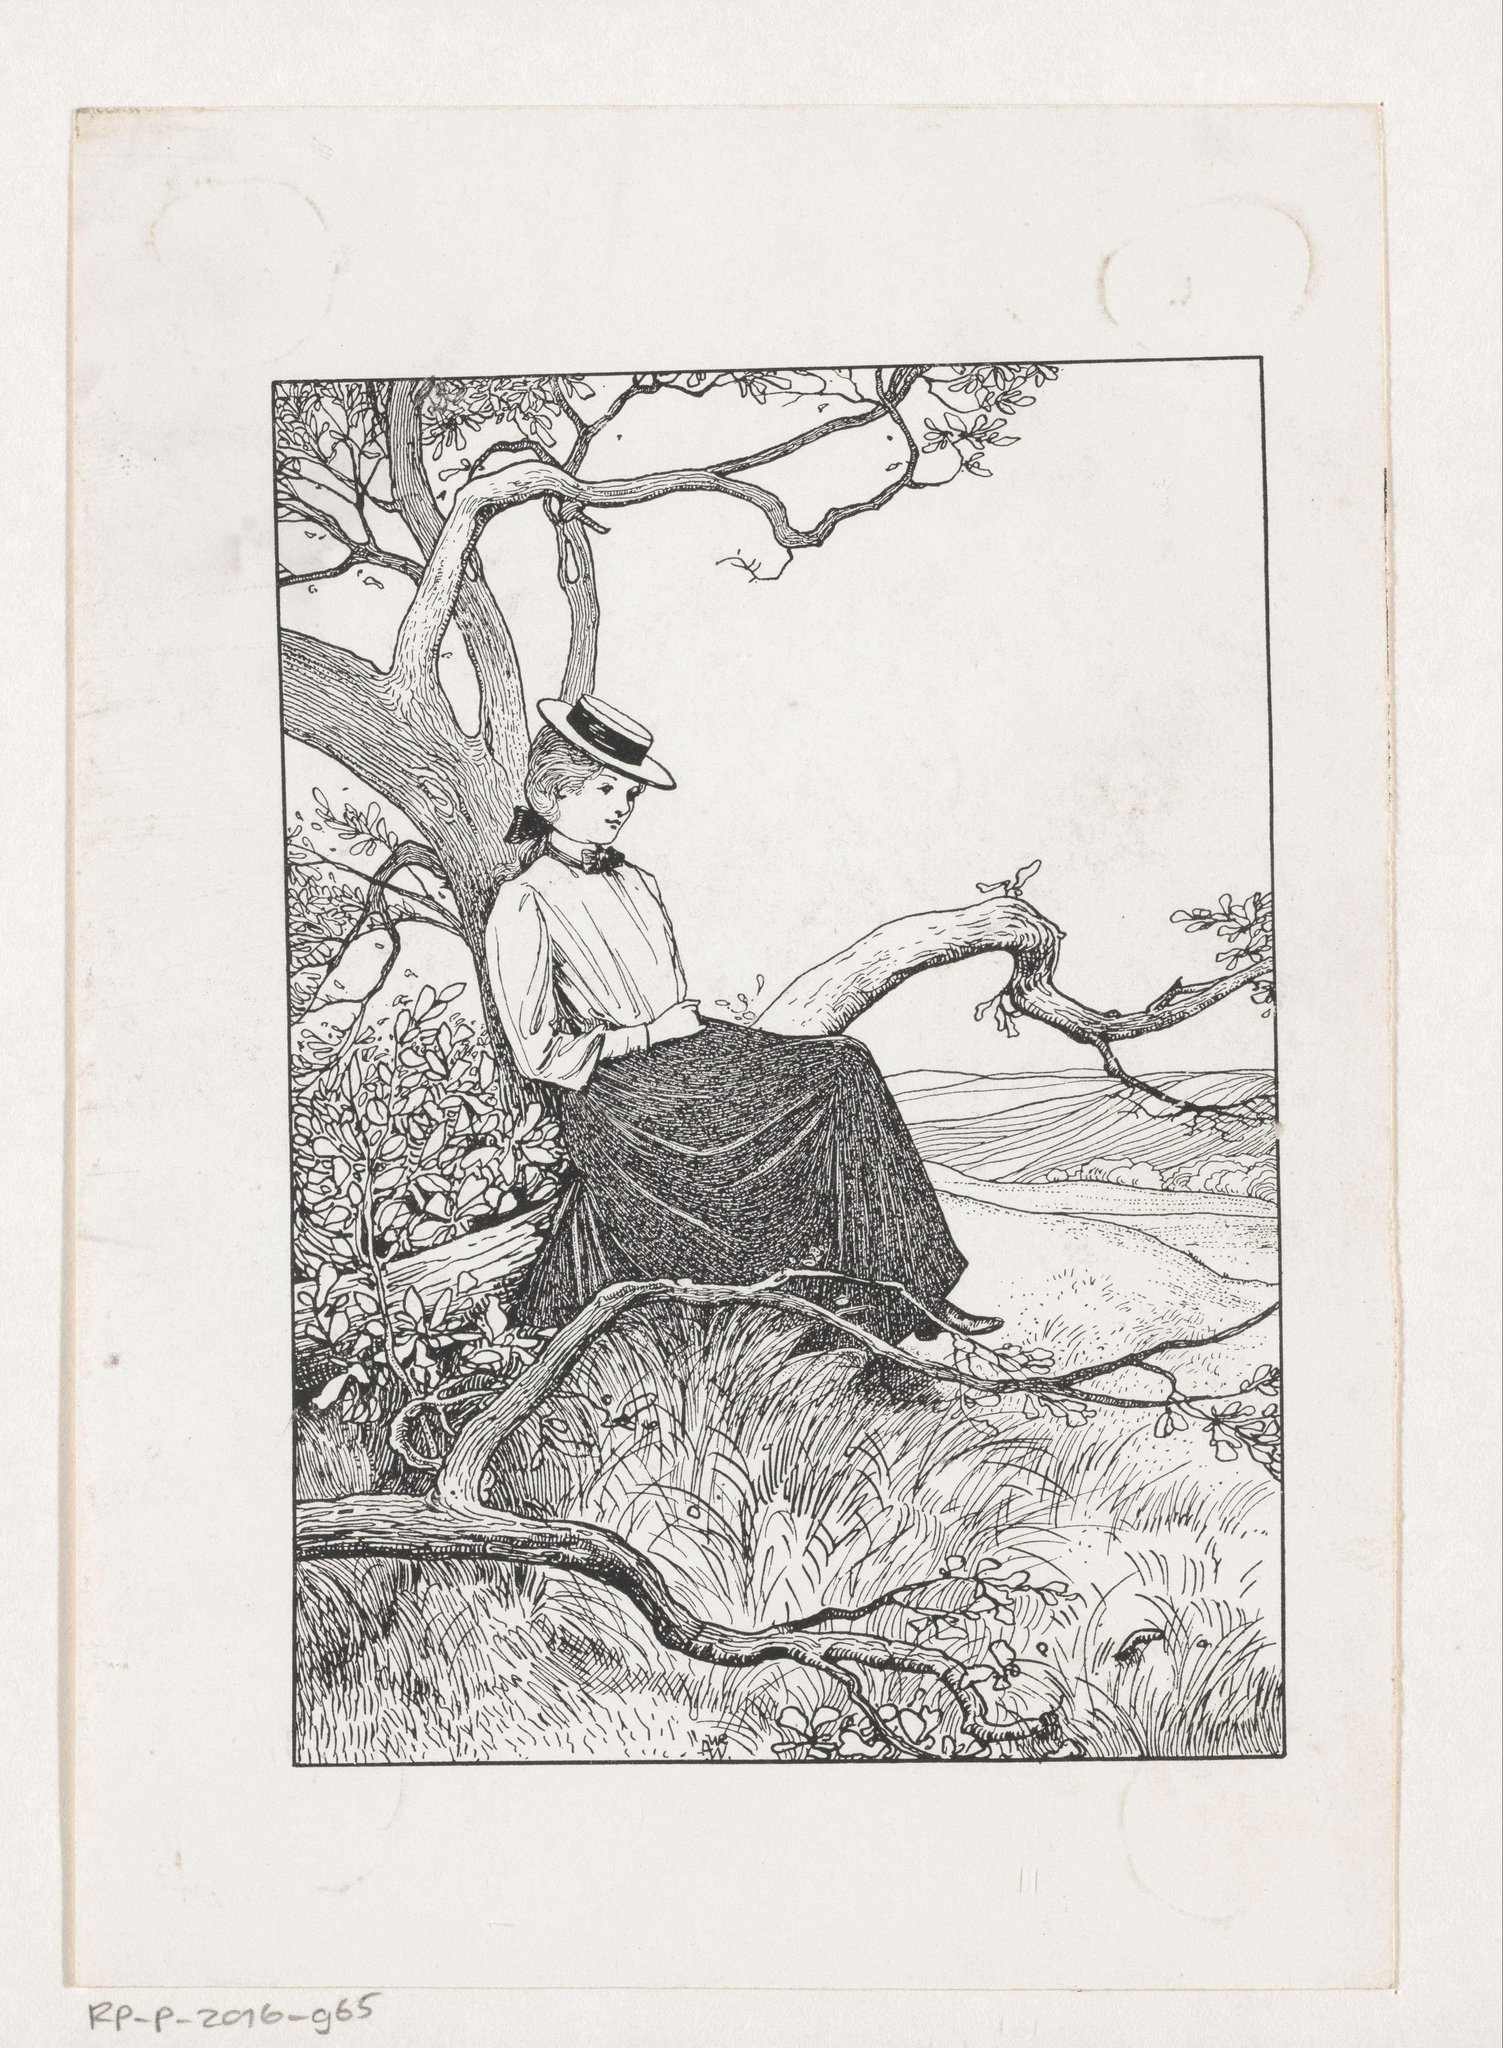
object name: photomechanical print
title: Zittend meisje op een boomtak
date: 1870-1937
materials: paper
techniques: printing block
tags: trees (+ stem, trunk), landscapes (+ landscape with figures, staffage)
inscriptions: collector's mark: Lugt 2228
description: Een meisje, gekleed in een lange rok, blouse met strik en een hoed, zit in een landschap op een omgevallen boomtak en staart voor zich uit.